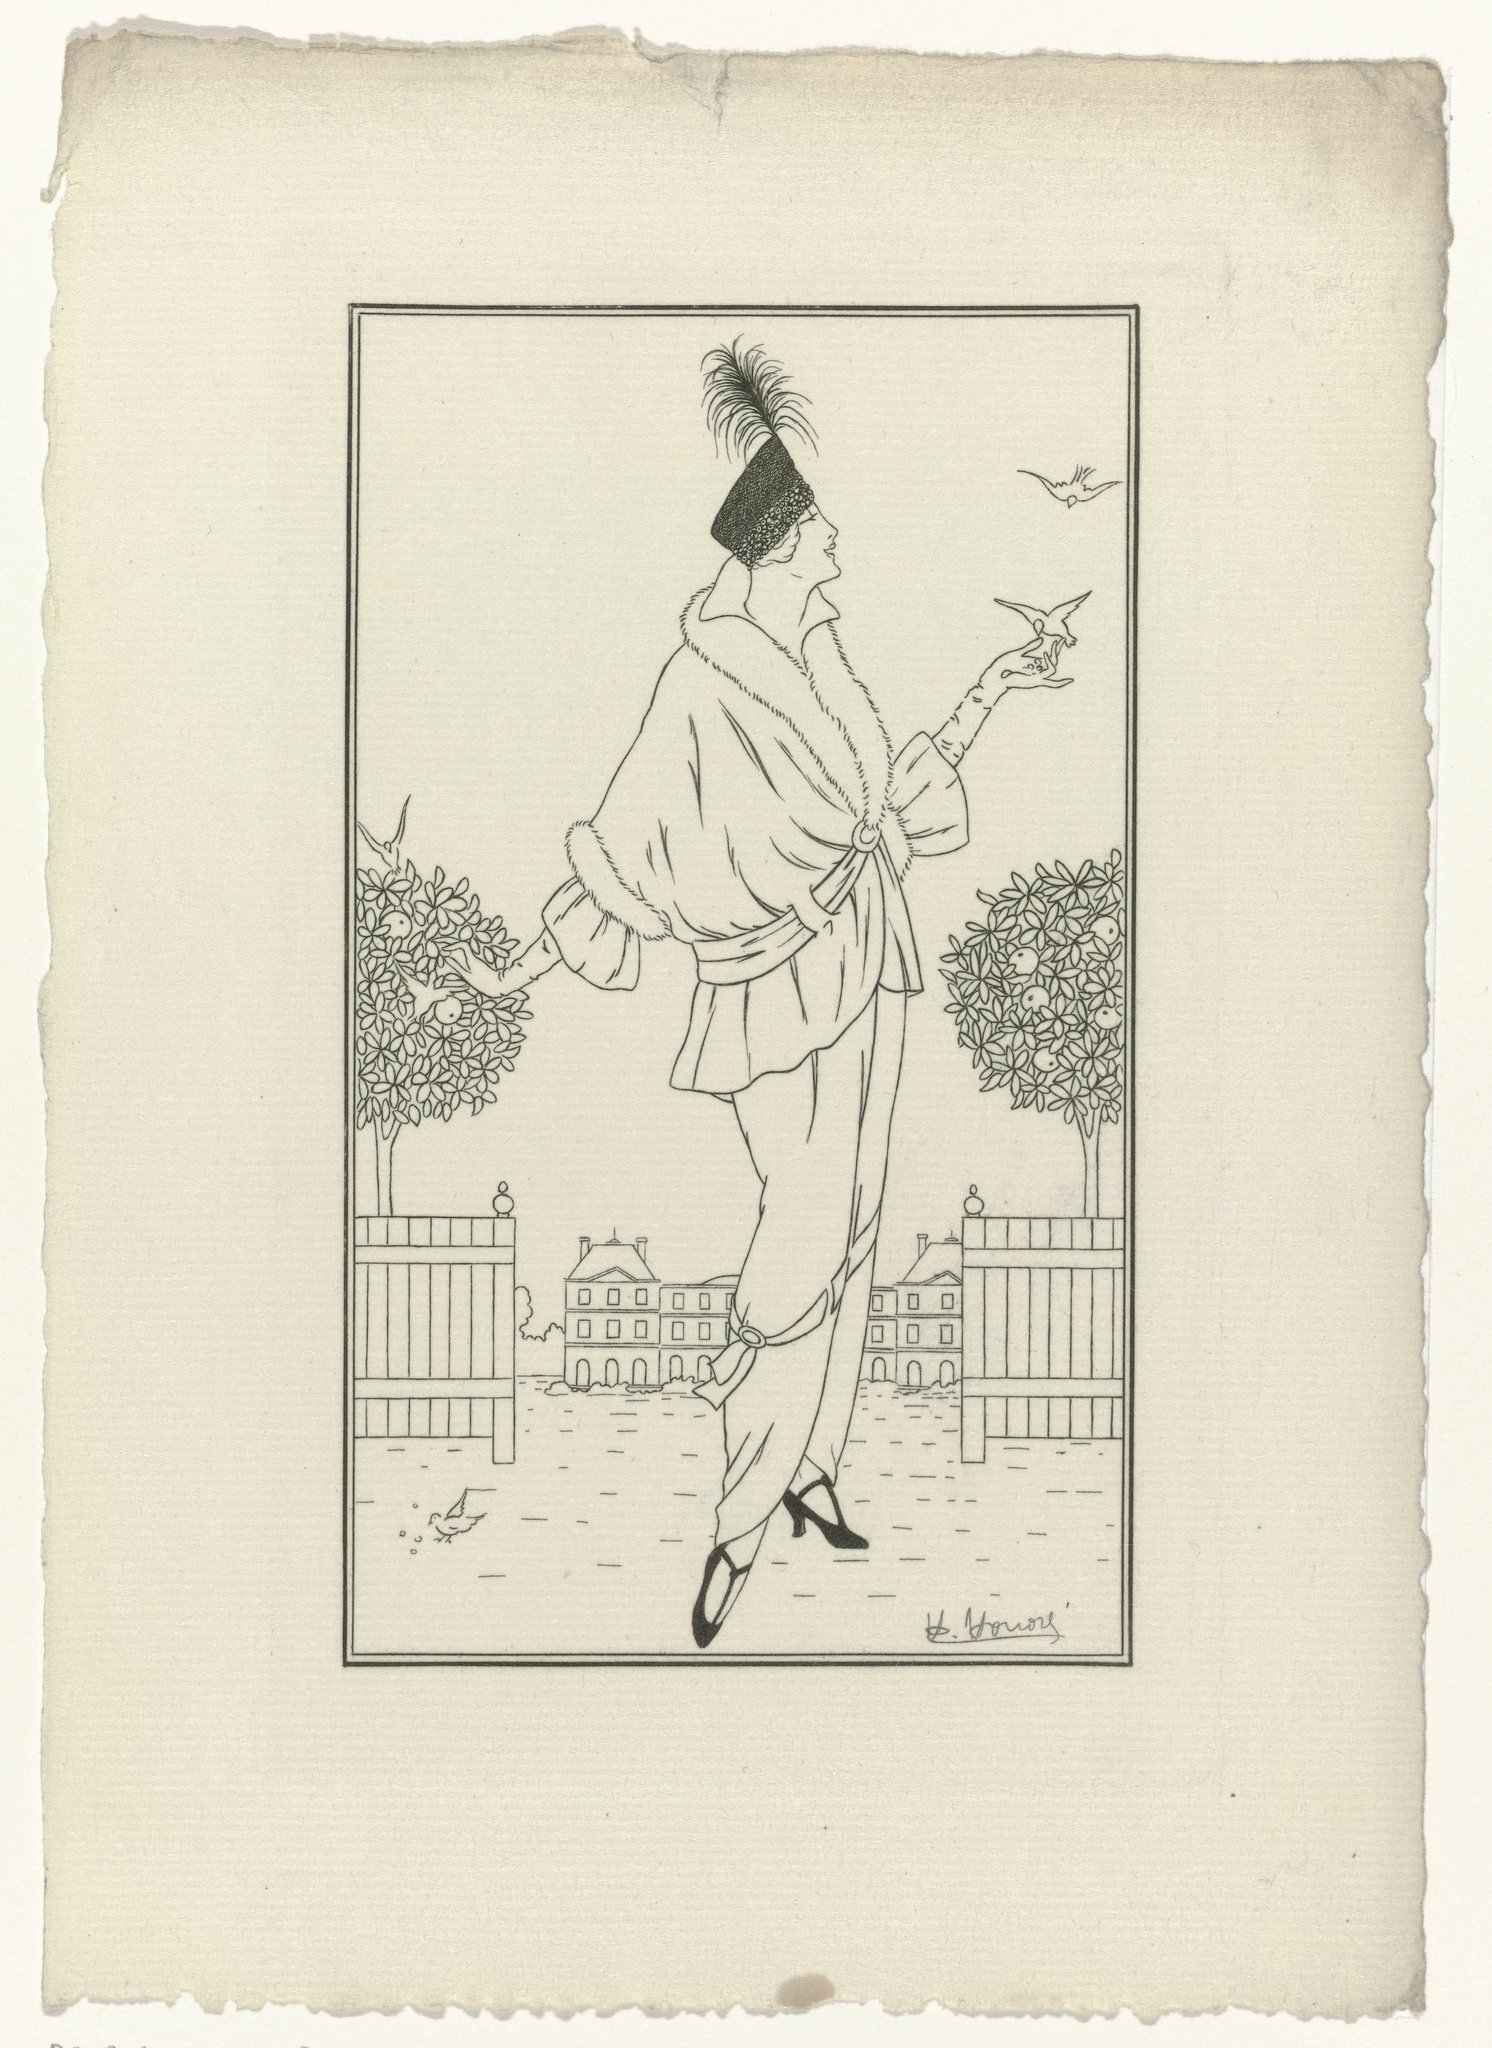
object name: fashion print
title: Journal des Dames et des Modes, Costumes Parisiens, 1914, No. 141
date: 1914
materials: paper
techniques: engraving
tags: head-gear: toque (+ women's clothes), birds (+ man and animal), coat (+ fur used for clothes), coat (+ women's clothes), fashion plates, feeding wild animals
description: Vrouw in japon van lichtbruine 'duvetyn'. Mantel of 'paletot' afgezet met vossenbont. Zij is bezig de vogels te voeren. Proefdruk van een prent uit het modetijdschrift Journal des Dames et des Modes (1912-1914). Op de prent met tekst staat: Robe de satin pékiné à volants de nansouk.